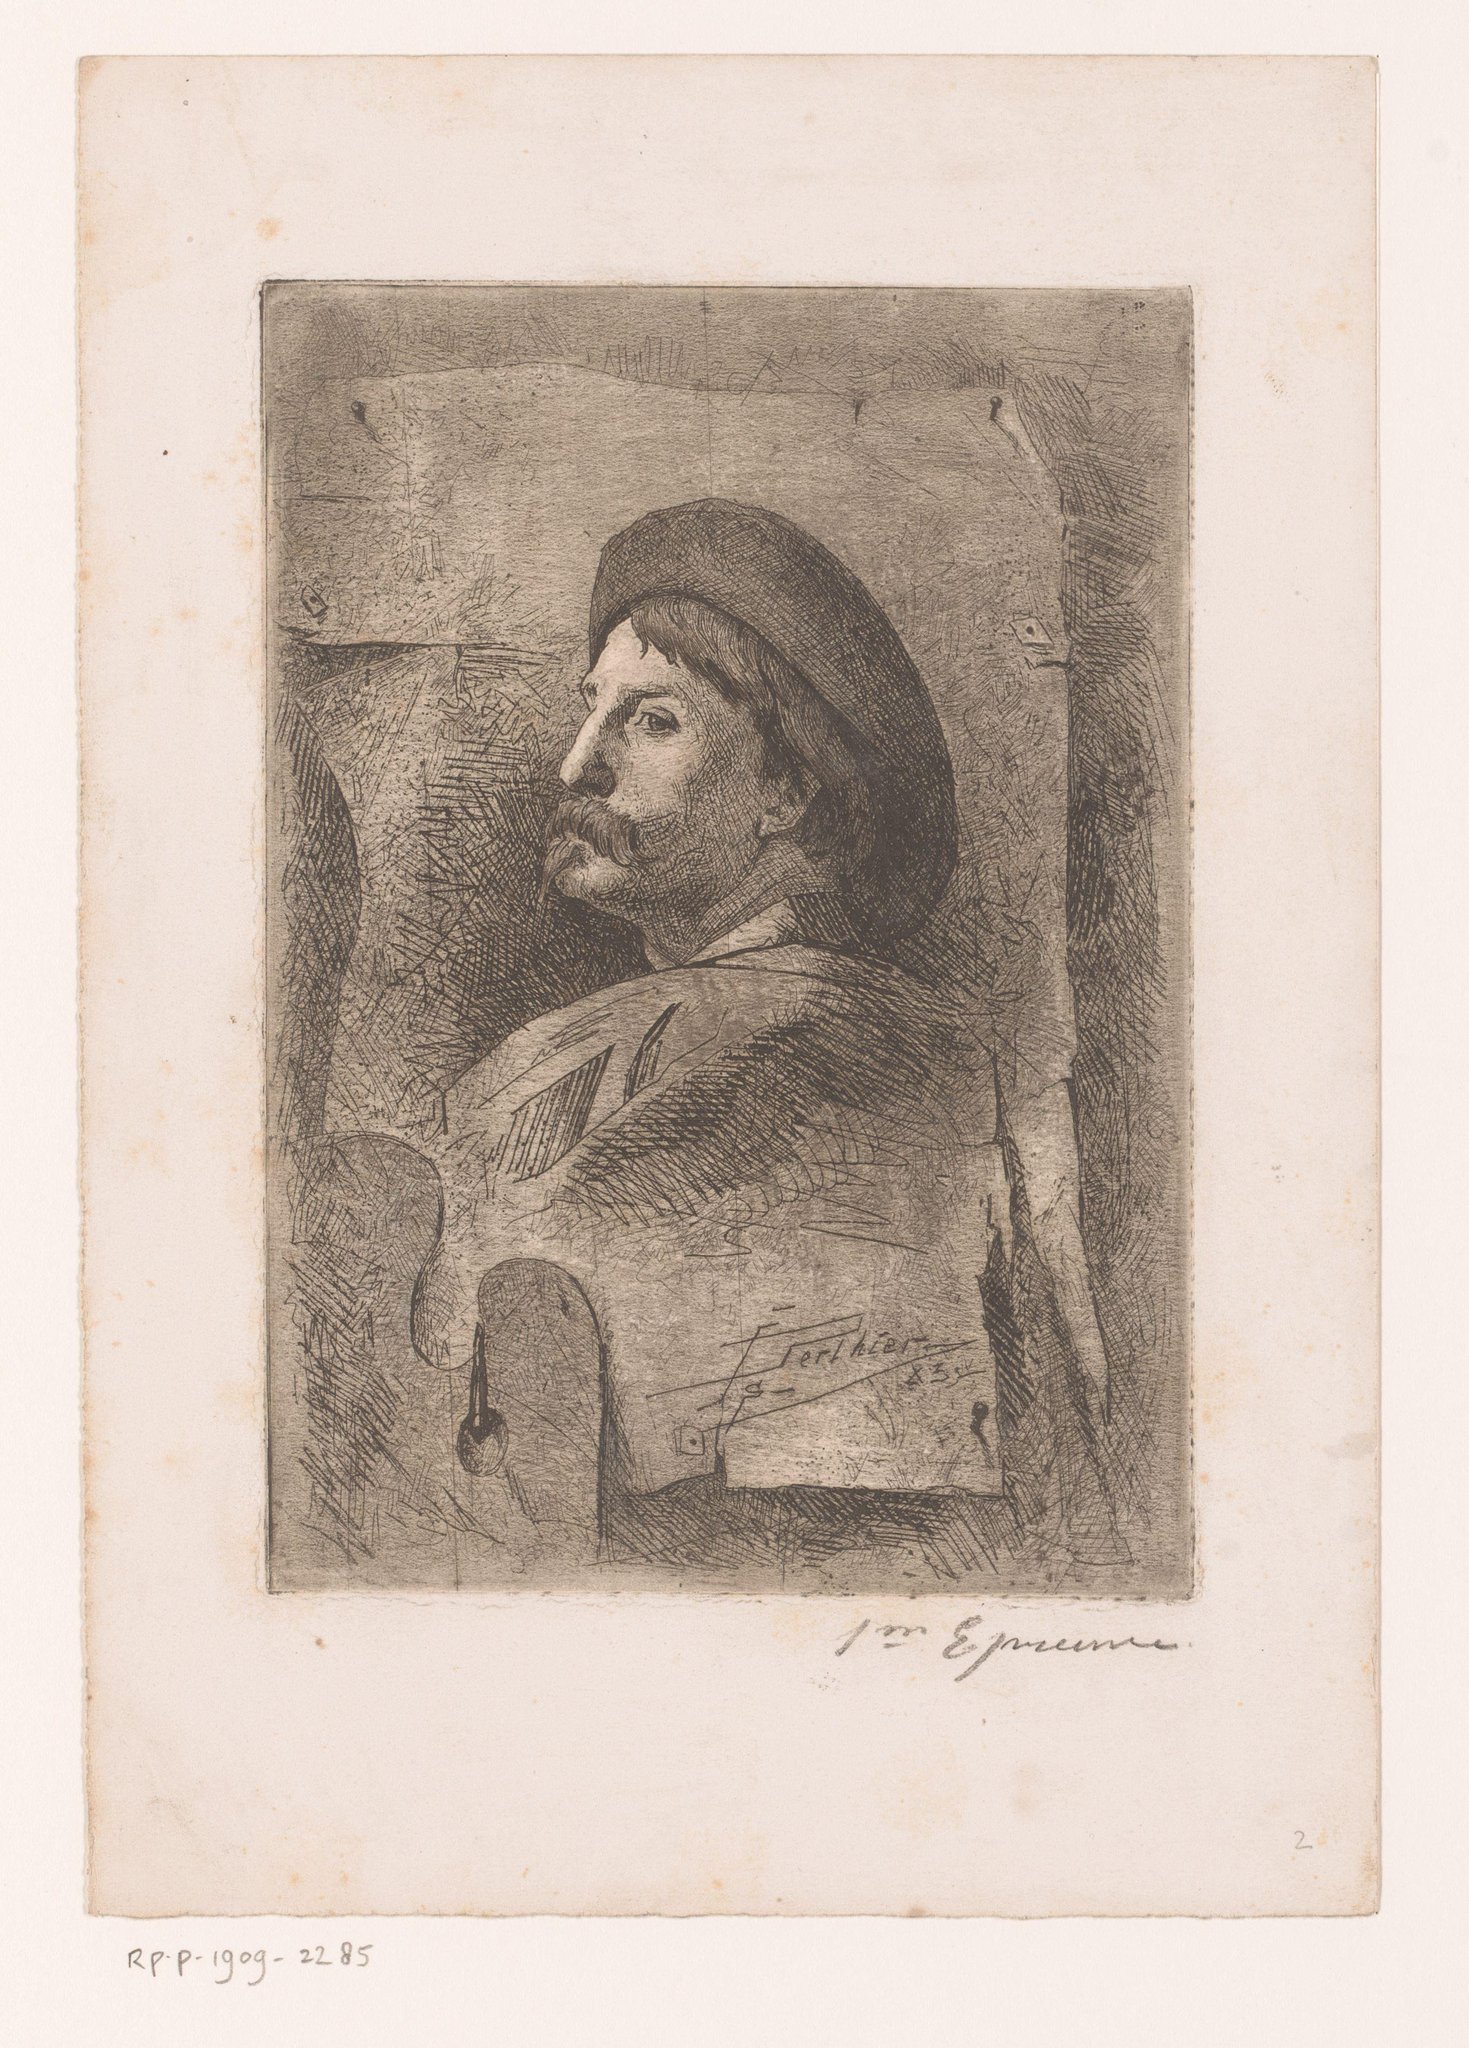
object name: print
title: Portret van een onbekende schilder met baret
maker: h. berthier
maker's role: print maker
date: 1903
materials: paper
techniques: etching, intaglio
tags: historical persons, portrait, self-portrait of painter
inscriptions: collector's mark: Lugt 2228, inscription: ‘1nr Epreuve’